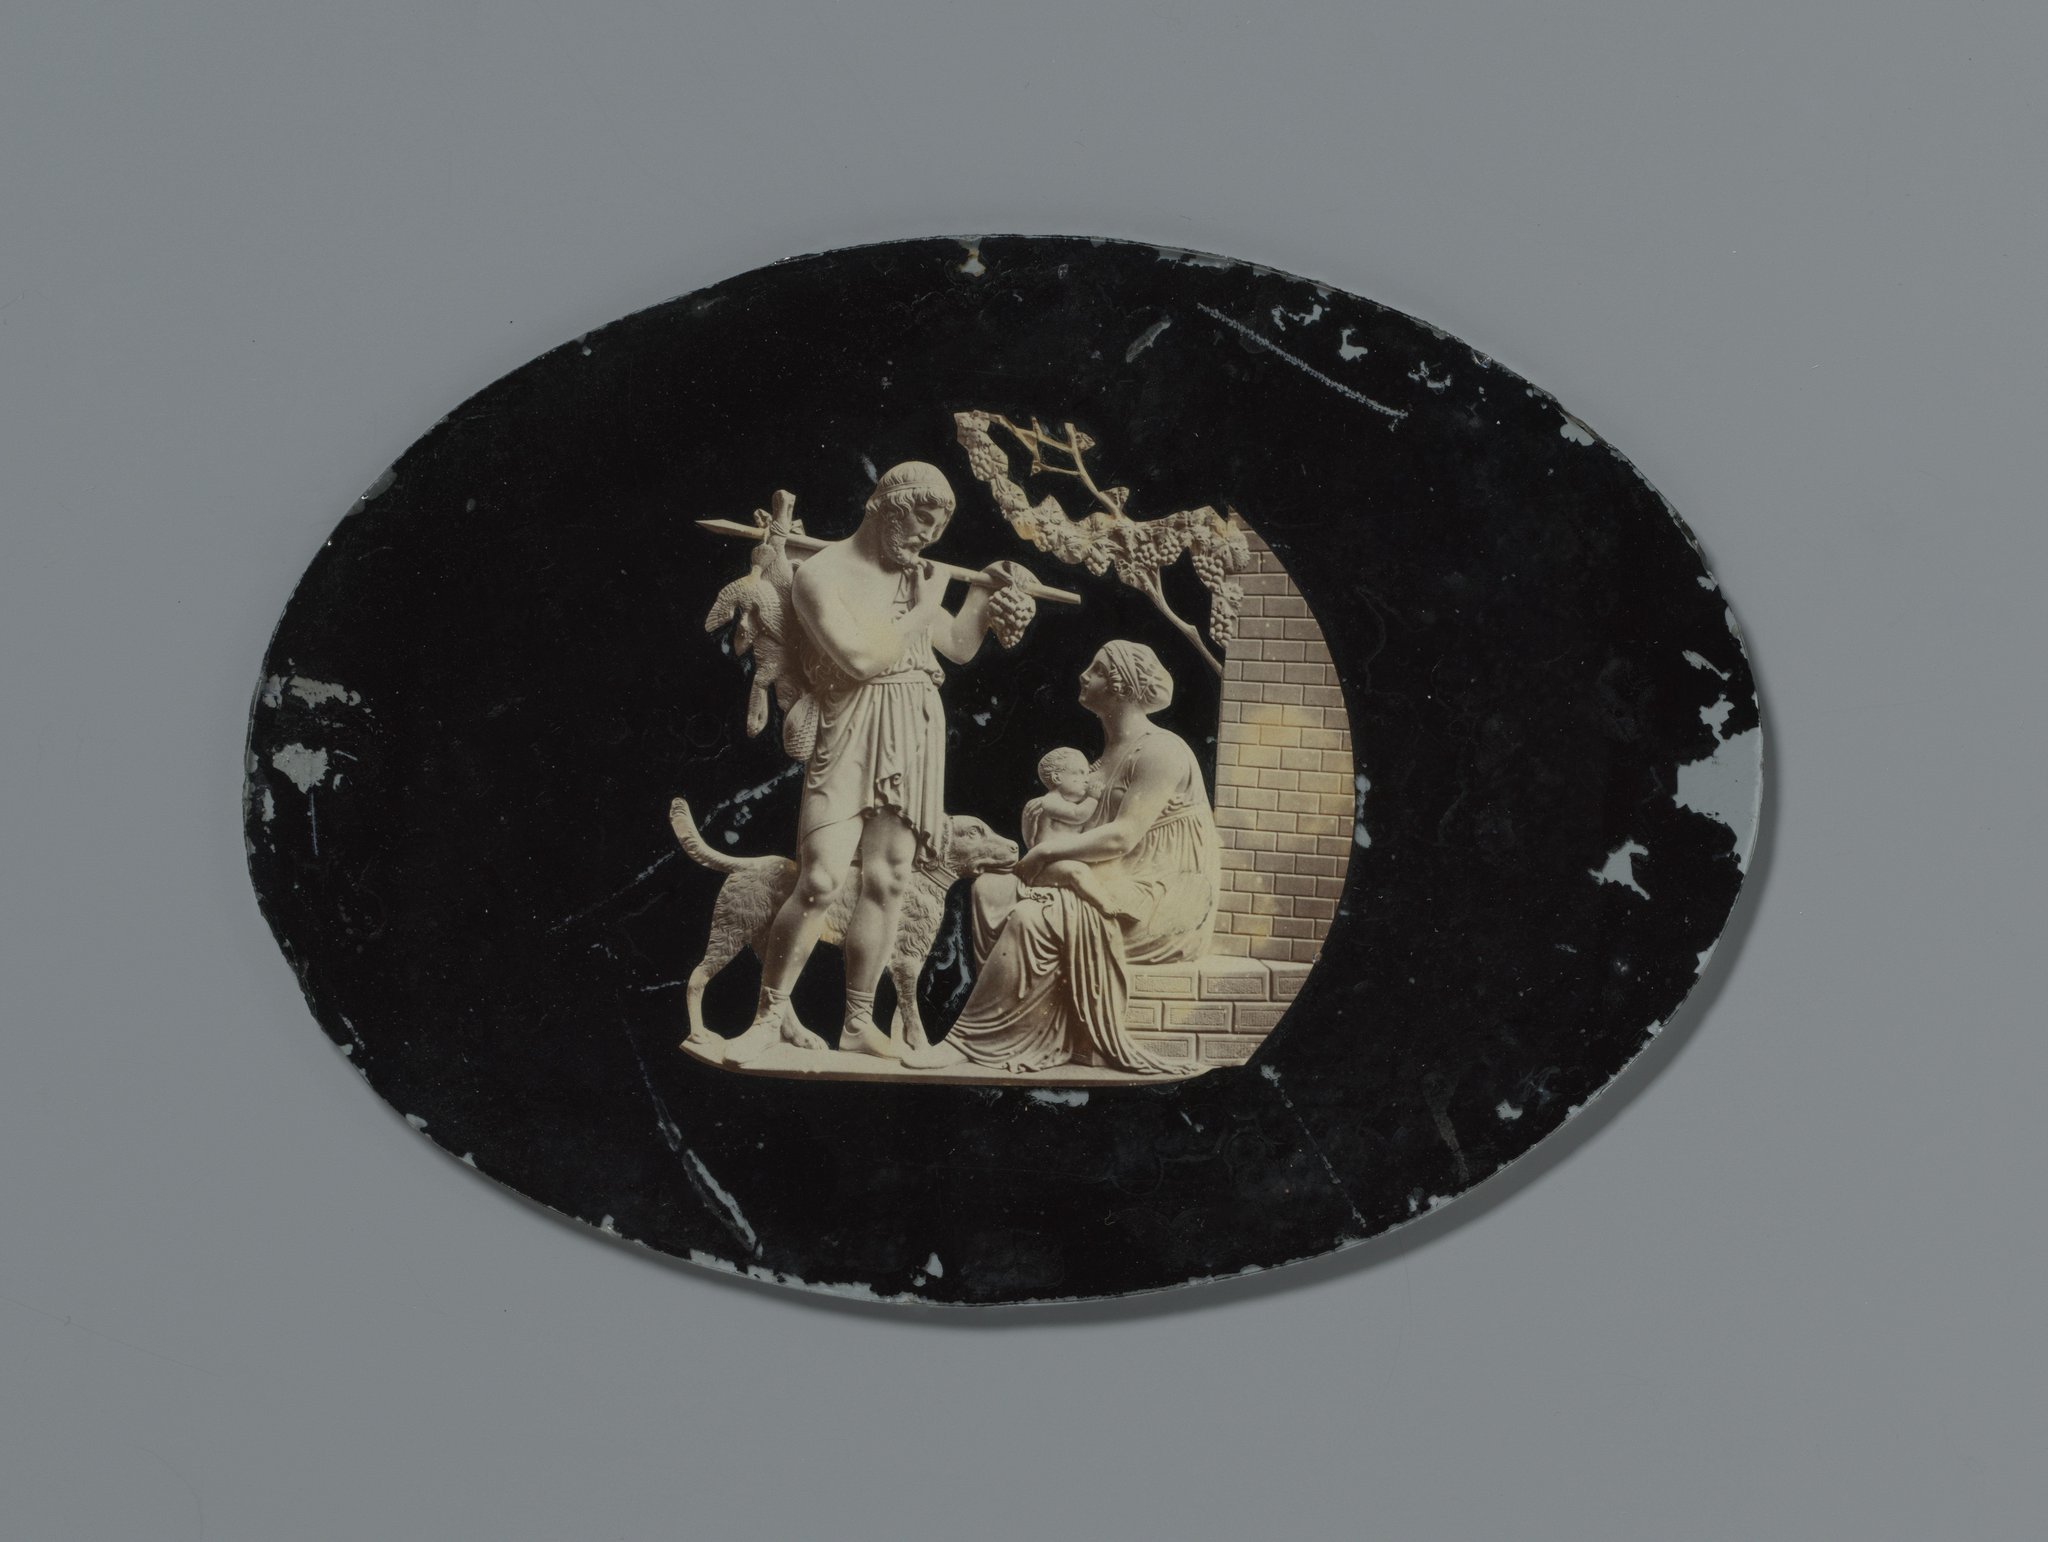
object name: photograph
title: Sculptuur van een Romeins tafereel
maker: Anonymous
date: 1850-1900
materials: glass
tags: adult woman, adult man, sculpture, dog